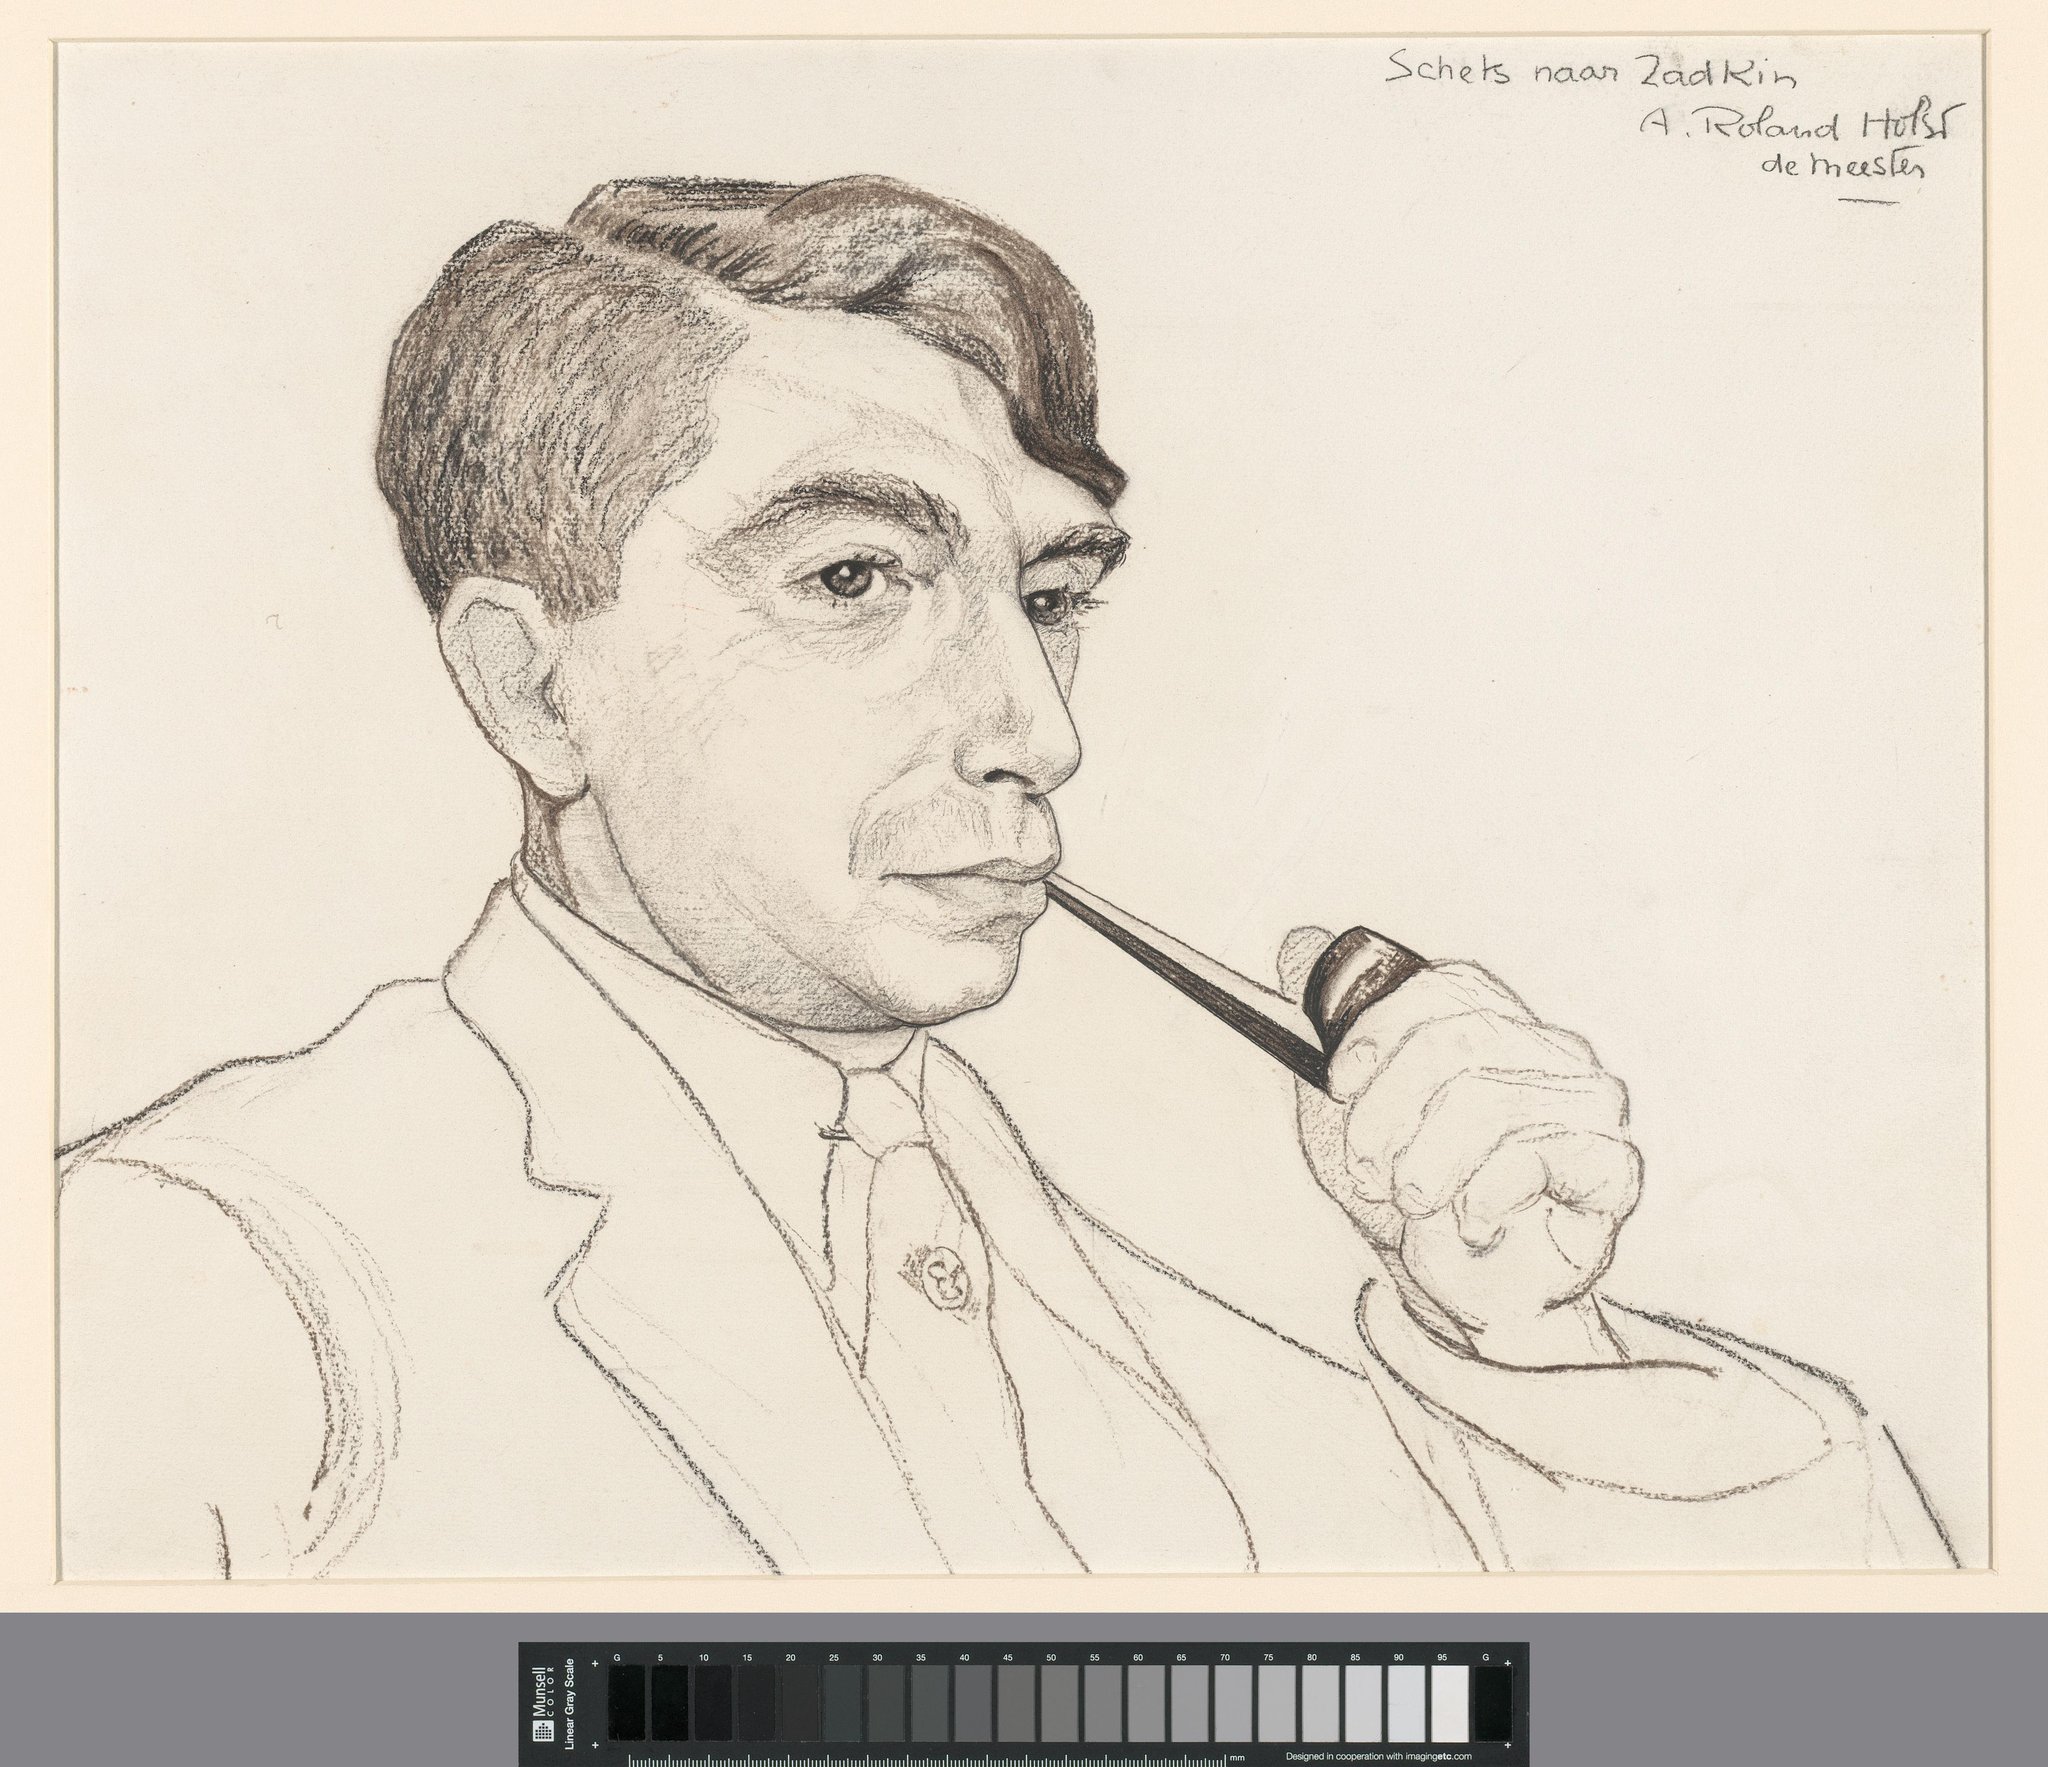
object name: drawing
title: Portret van Ossip Zadkine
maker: annie roland holst-de meester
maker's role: draughtsman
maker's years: 1893-1987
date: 1903-1962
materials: chalk, paper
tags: print maker, sculptor, ossip zadkine, portrait, self-portrait of sculptor, historical persons, portrait, self-portrait of artist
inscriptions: collector's mark: Lugt 2228